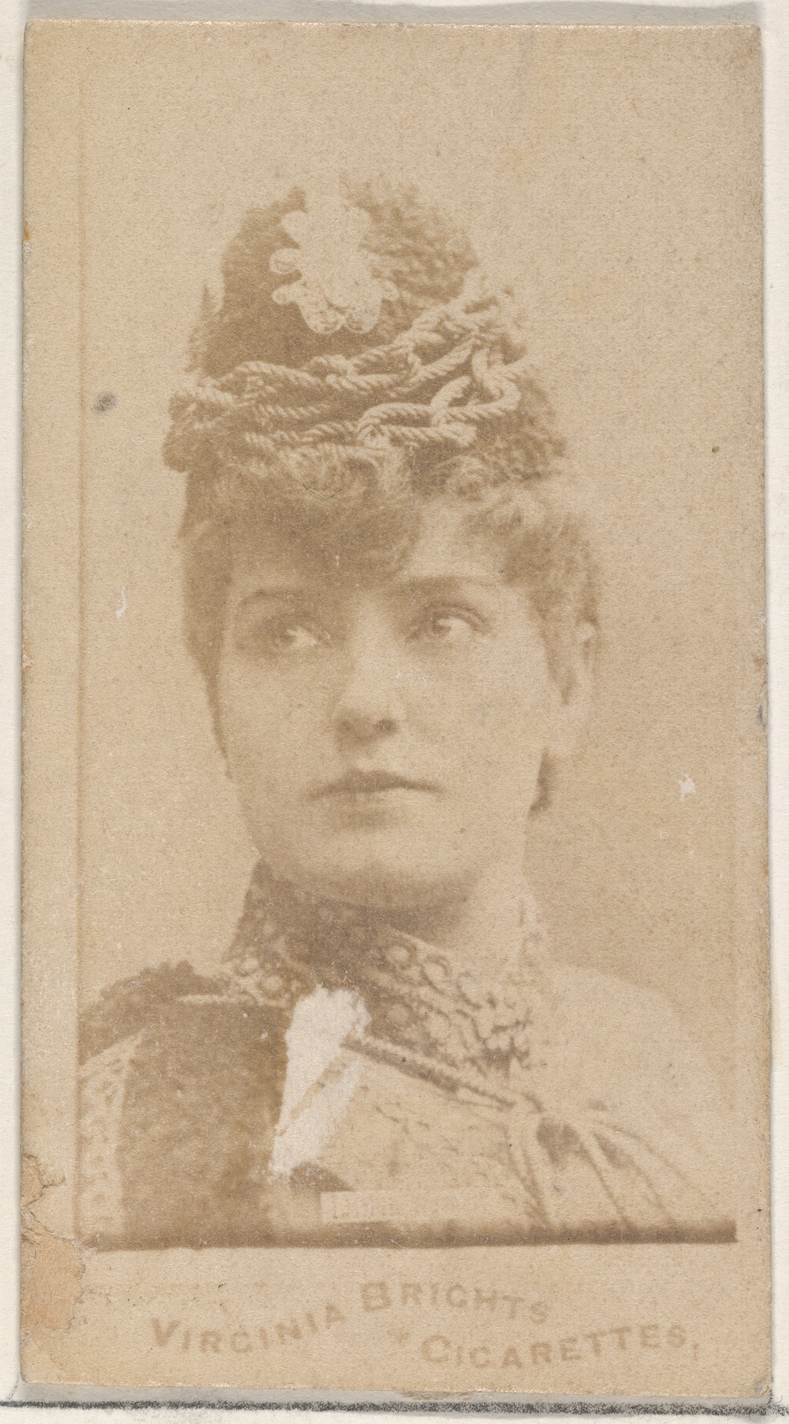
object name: photograph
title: From the Actors and Actresses series (N45, Type 4) for Virginia Brights Cigarettes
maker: allen & ginter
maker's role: publisher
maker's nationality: american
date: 1888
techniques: albumen silver print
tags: portraits,women,actresses